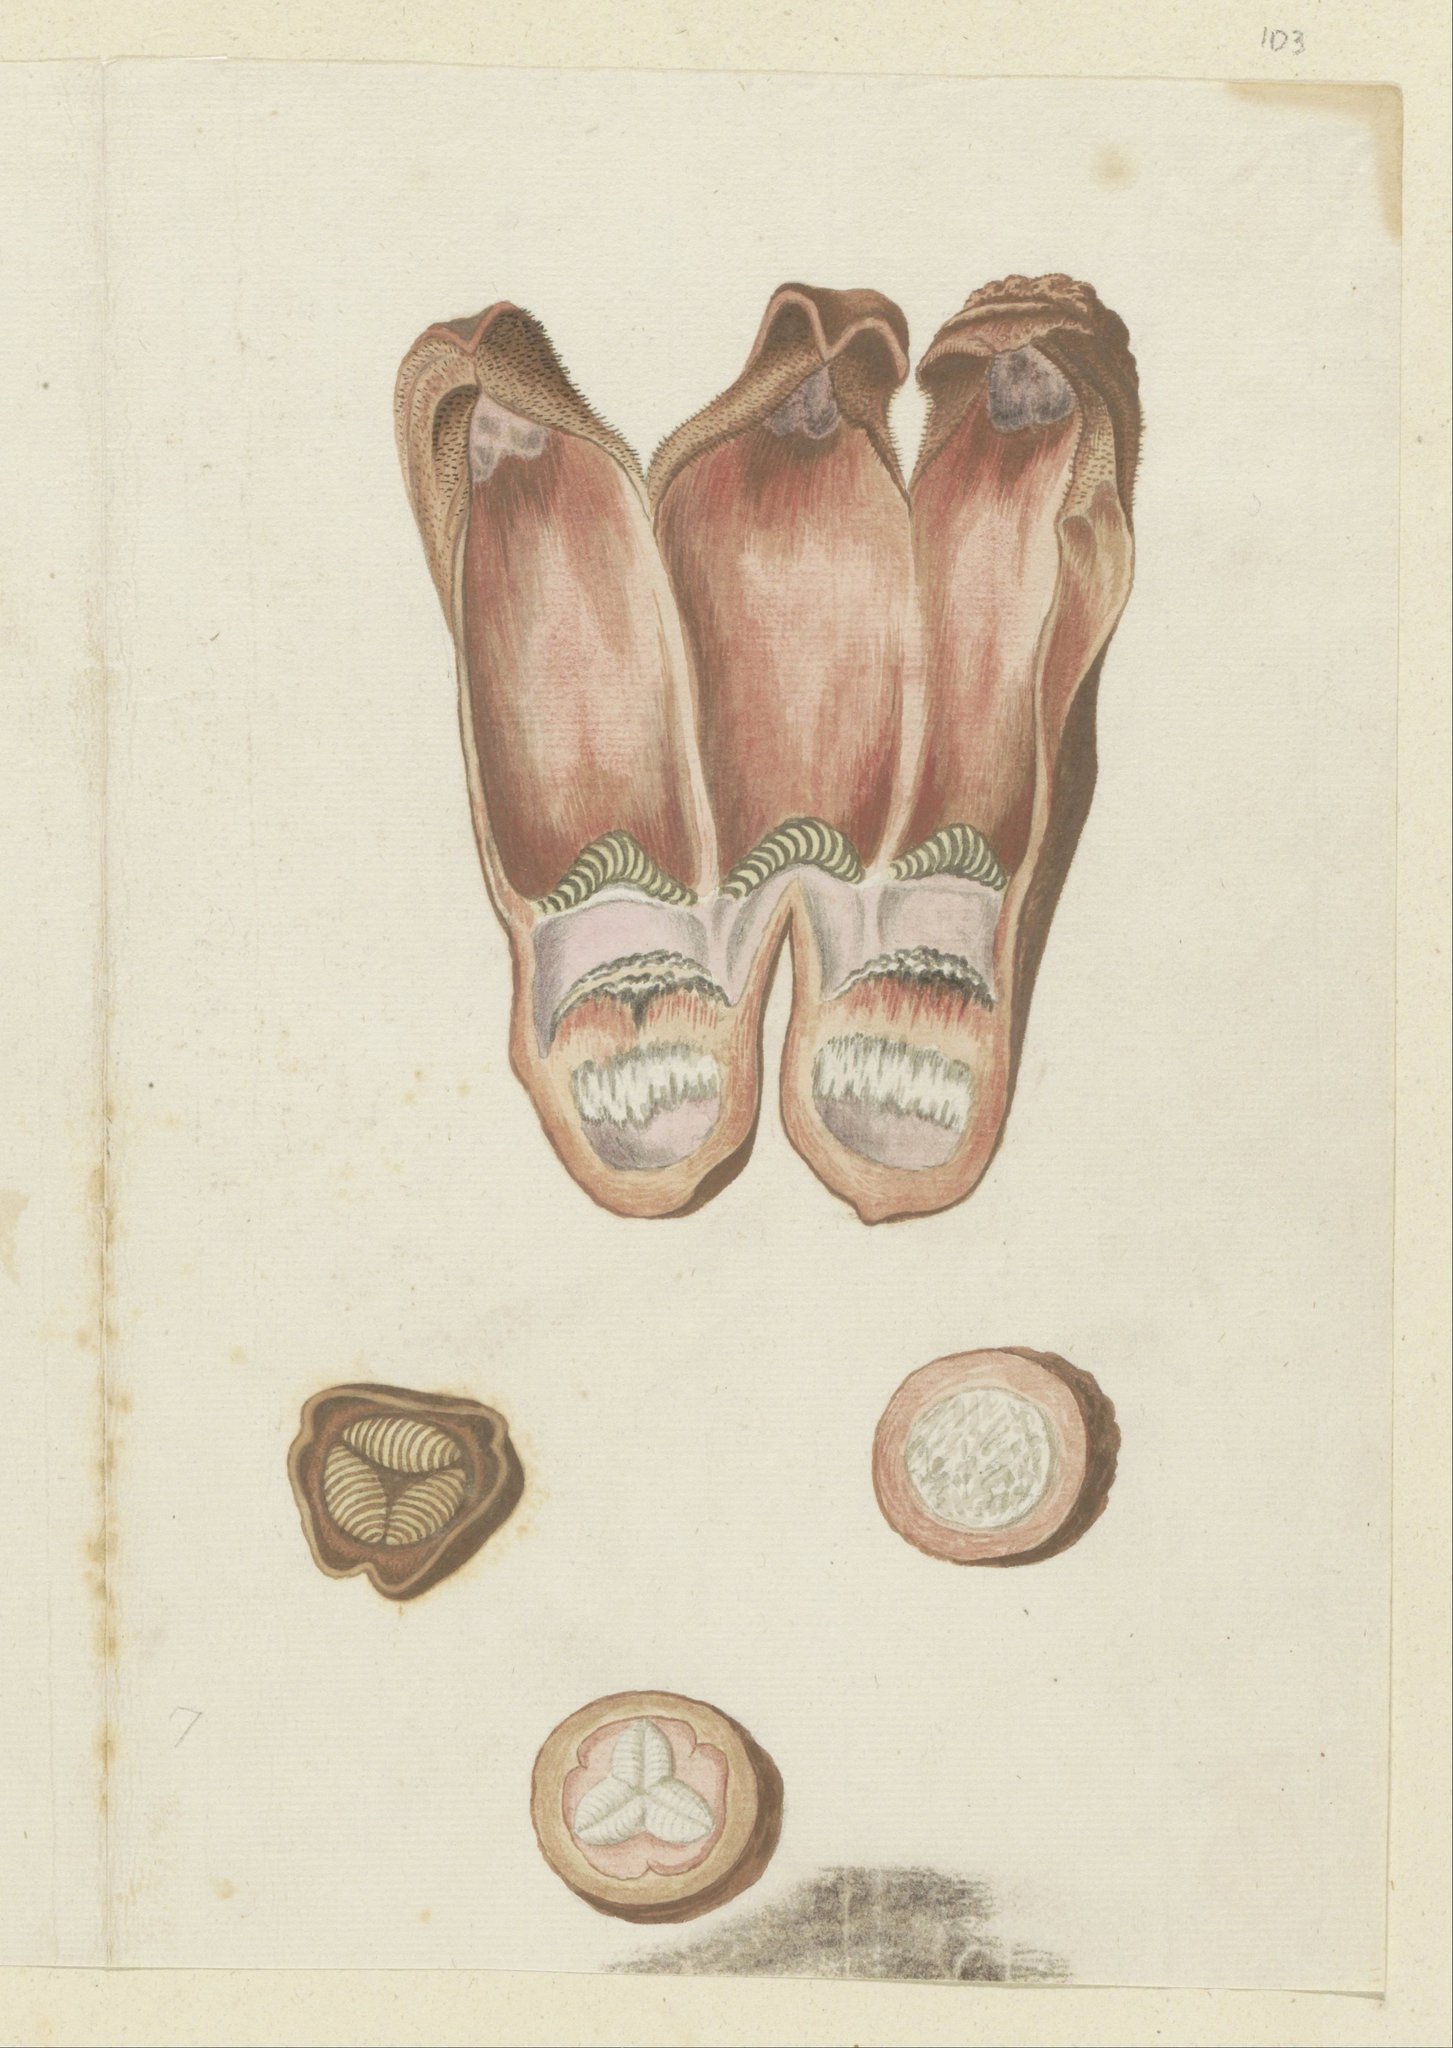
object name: album leaf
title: Hydnora africana Thunb., details (Jackal-food plant)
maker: robert jacob gordon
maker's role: draughtsman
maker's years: 1743-1795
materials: chalk, ink, paper, pencil, watercolor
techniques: brush, pen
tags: plants; vegetation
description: De tekening is gemaakt voor of tijdens een van Gordon's vier expedities door de Kaapprovincie, van oktober 1777 tot maart 1786. Sommige (soort)namen kunnen zijn gewijzigd, gezien reorganisatie in plantentaxonomie gedurende de afgelopen jaren.